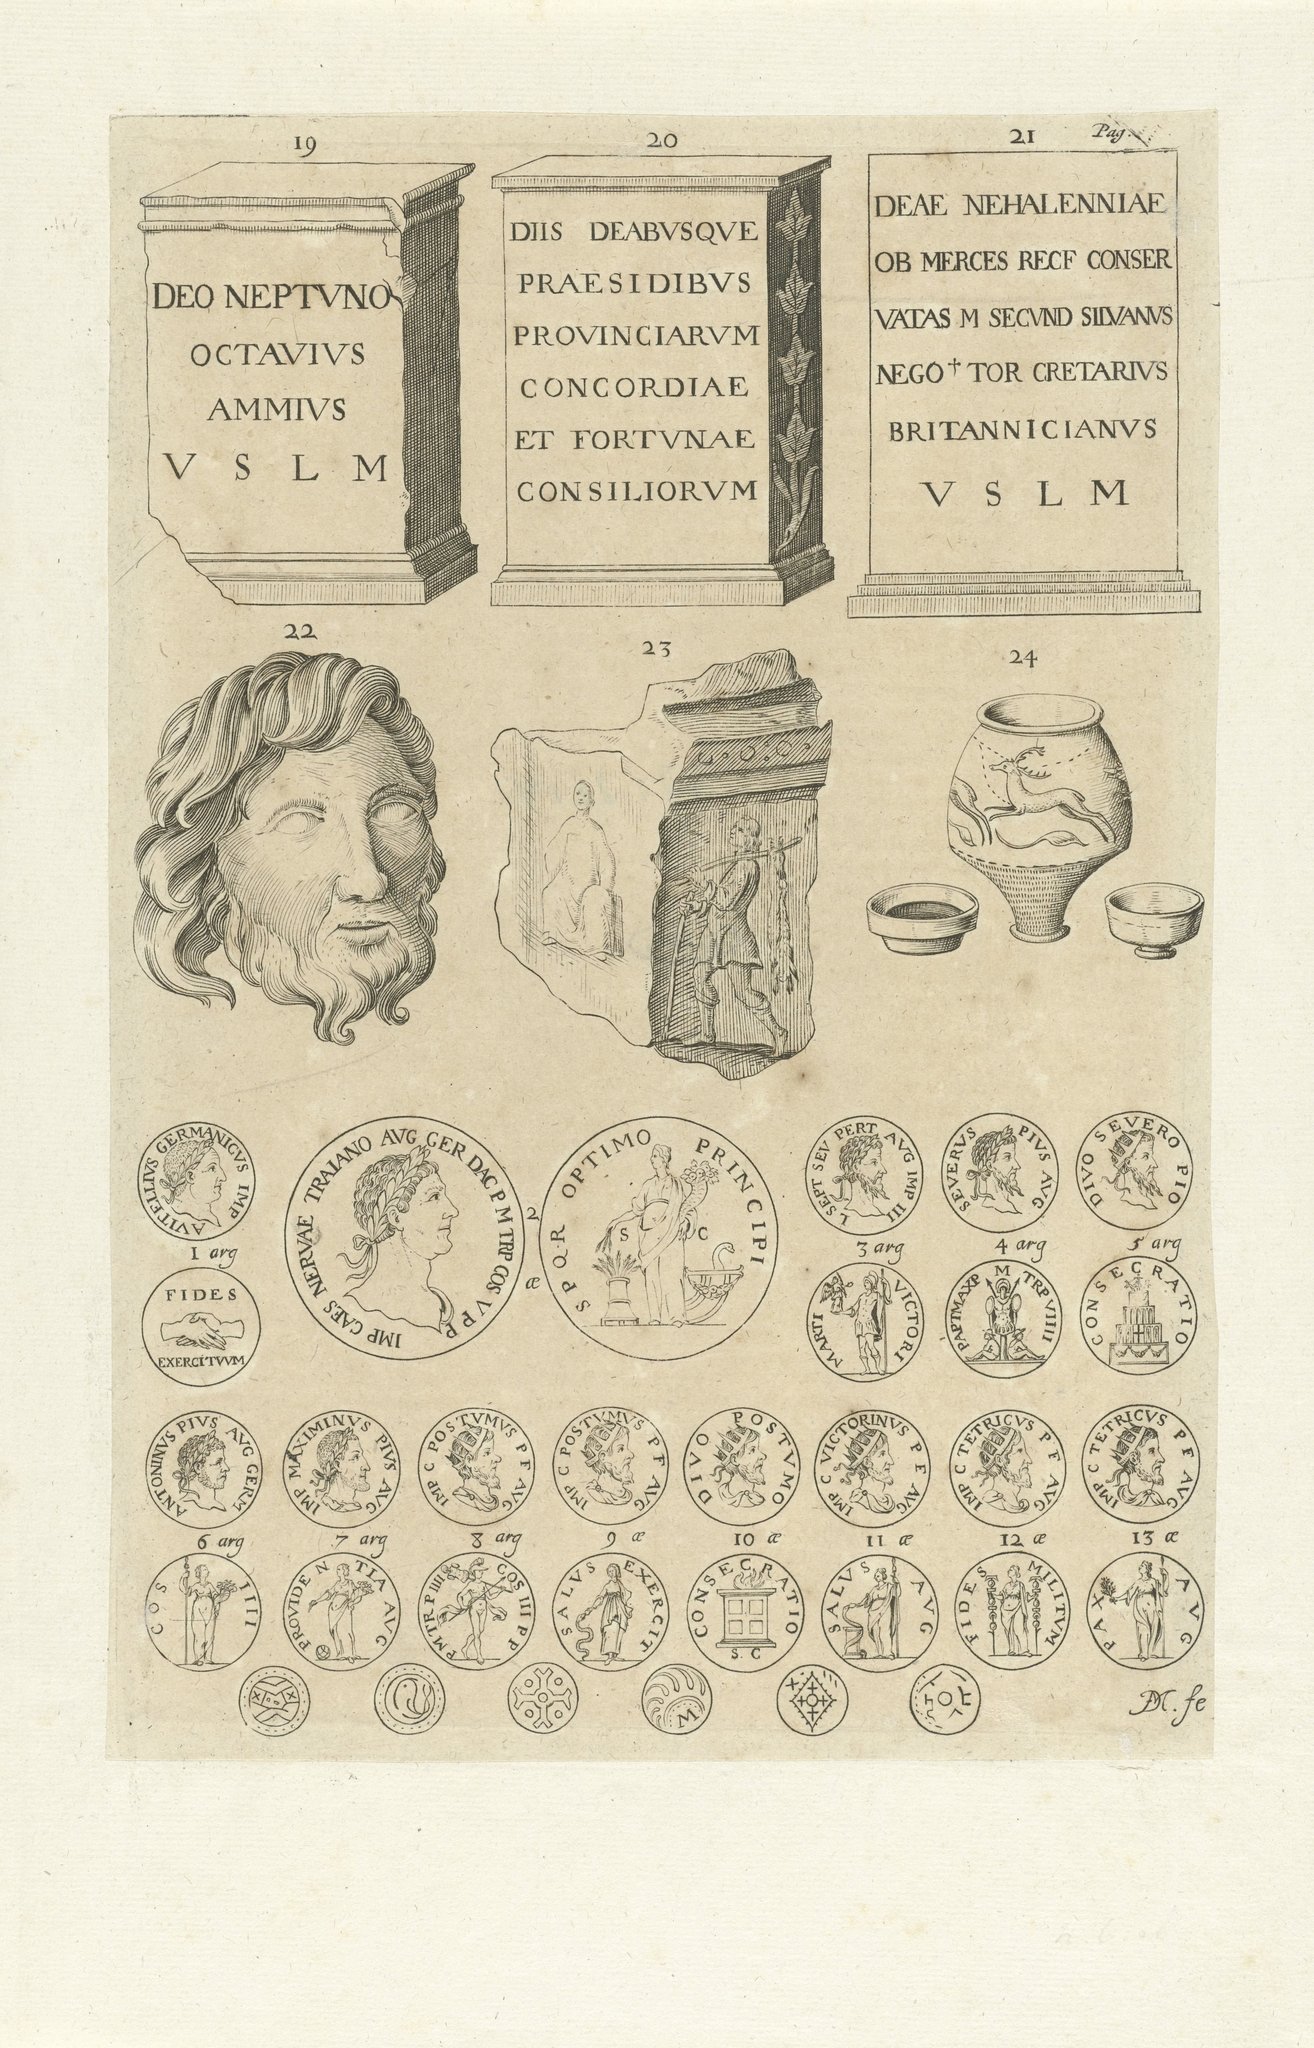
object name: book illustration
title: Altaarstenen, sculpturen en Romeinse munten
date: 1725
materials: paper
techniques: engraving, etching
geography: leiden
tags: altar ~ germanic and scandiavian religions, coin, excavation ~ archaeology, other foreign deities included in the classical pantheon (with name), altar ~ roman religion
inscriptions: collector's mark: Lugt 2228, collector's mark: Lugt 2760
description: Drie genummerde altaarstenen, waarvan de eerste is gewijd aan Neptunus en de derde aan de godin Nehalennia. De laatst genoemde werd in de tweede en derde eeuw na Christus in Zeeland werd aanbeden. Daaronder een manshoofd, een klassiek brokstuk en een vaas met daarop een hert. Onderaan Romeinse munten. Waarschijnlijk zijn het bodemvondsten uit Zeeland.